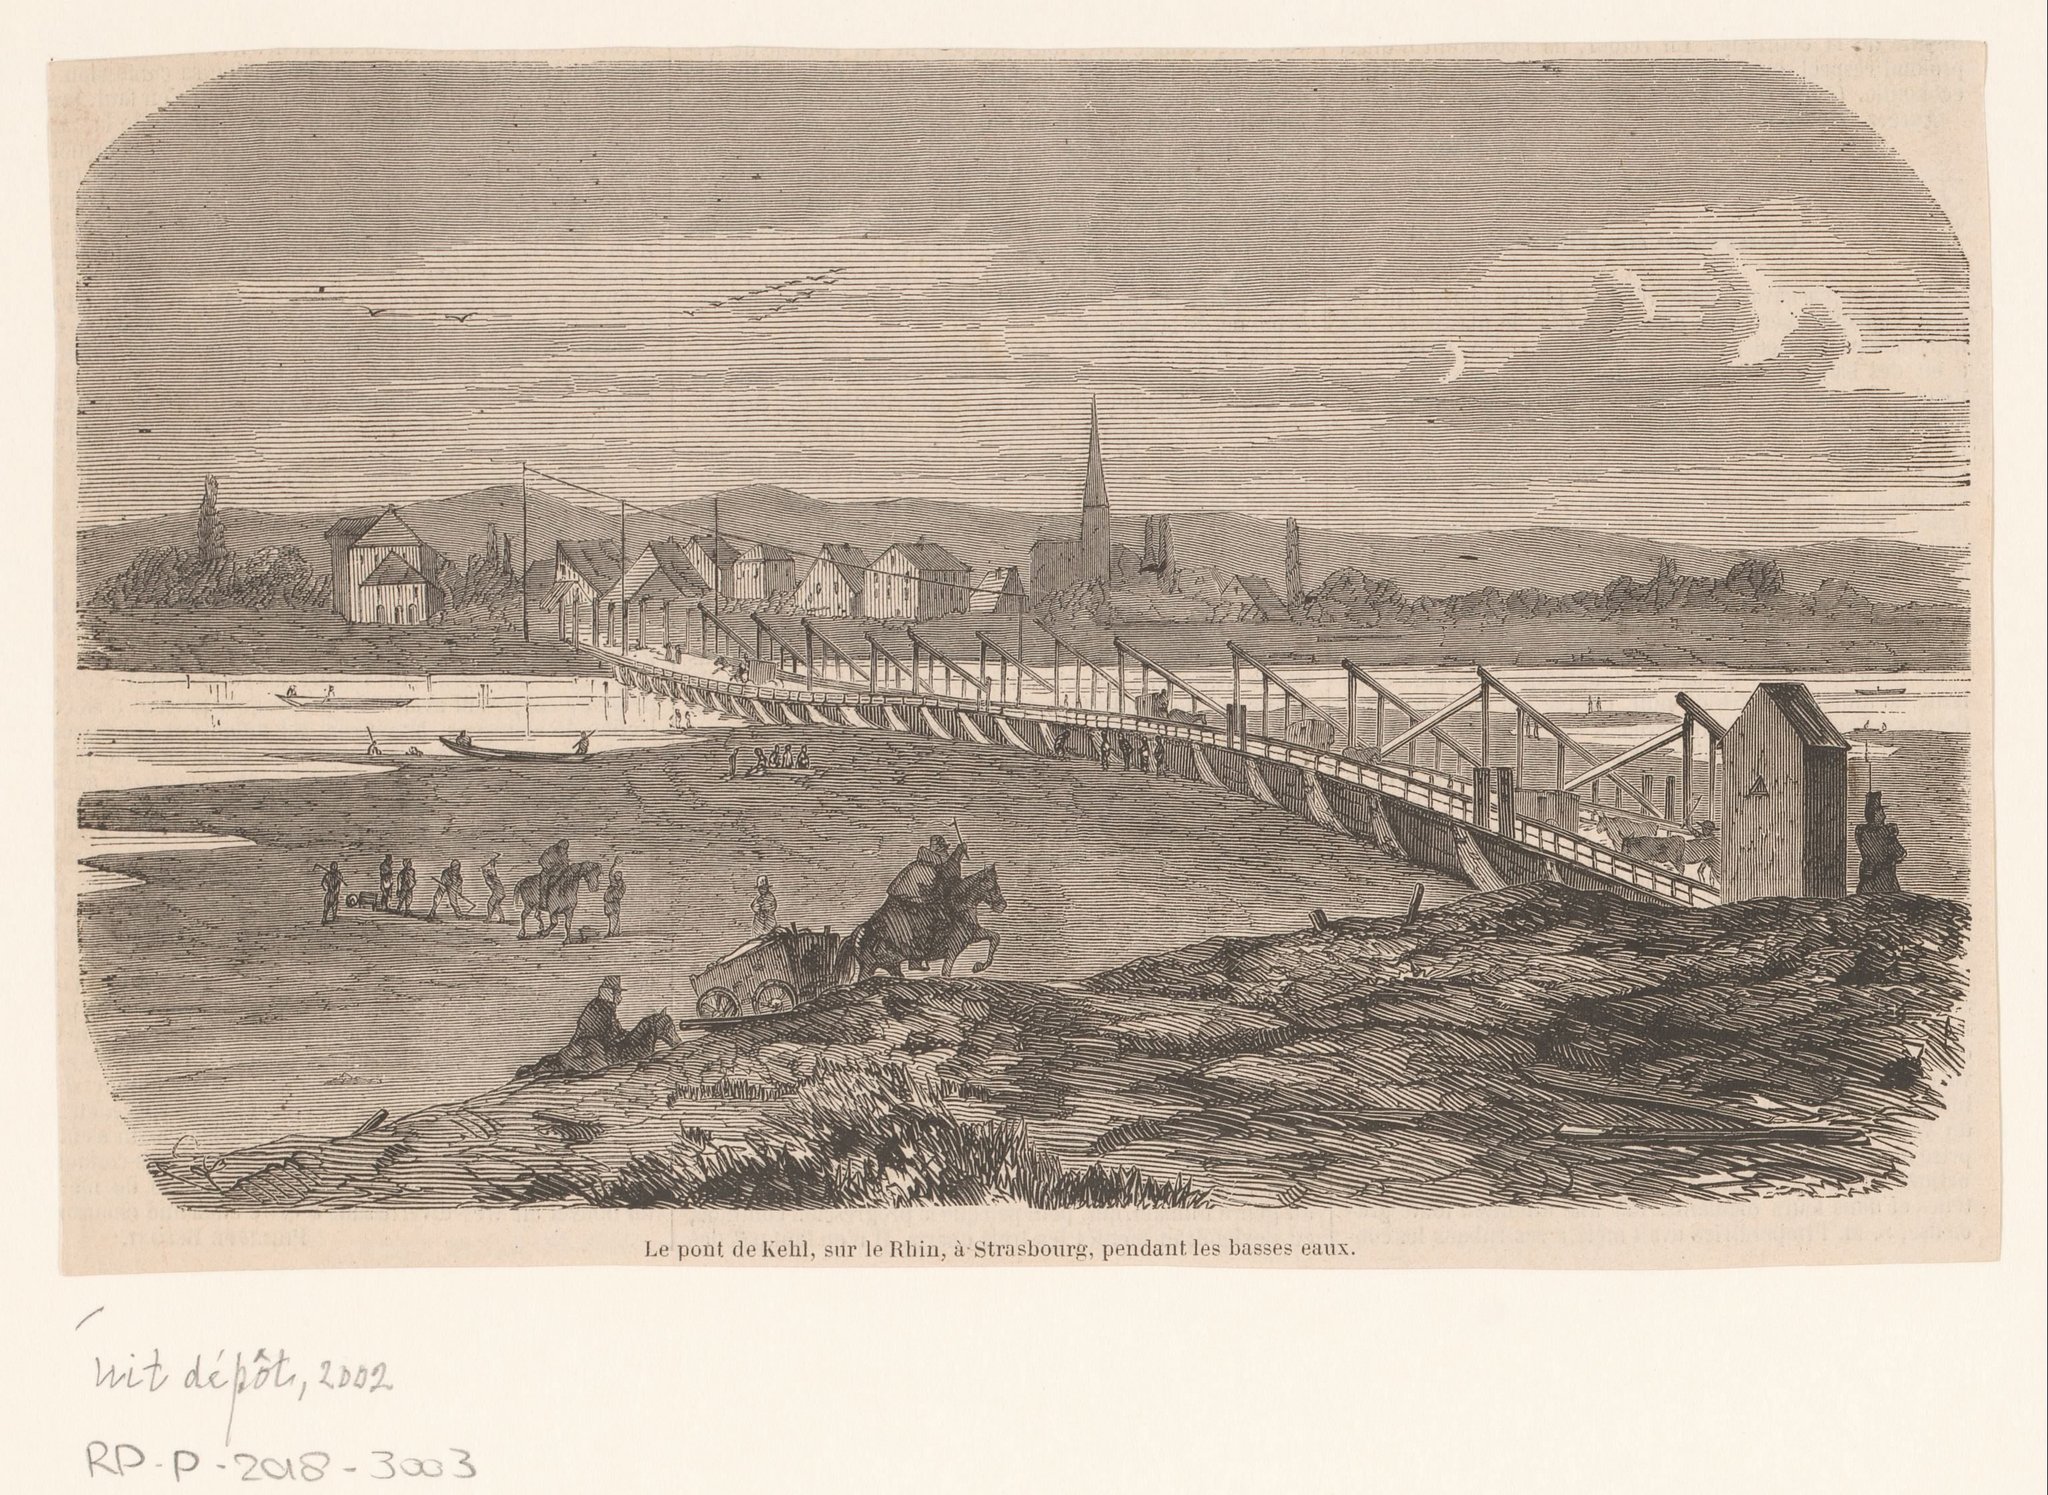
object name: book illustration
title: Le pont de Kehl, sur le Rhin, à Strasbourg, pendant les basses eaux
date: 1858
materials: paper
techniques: letterpress printing, engraving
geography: paris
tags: landscape with bridge, viaduct or aqueduct, bridge, bridge in city across river, canal, etc.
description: Prent uit: L'Illustration 31 (1858), nr. 780 6 februari 1858, p. 84.